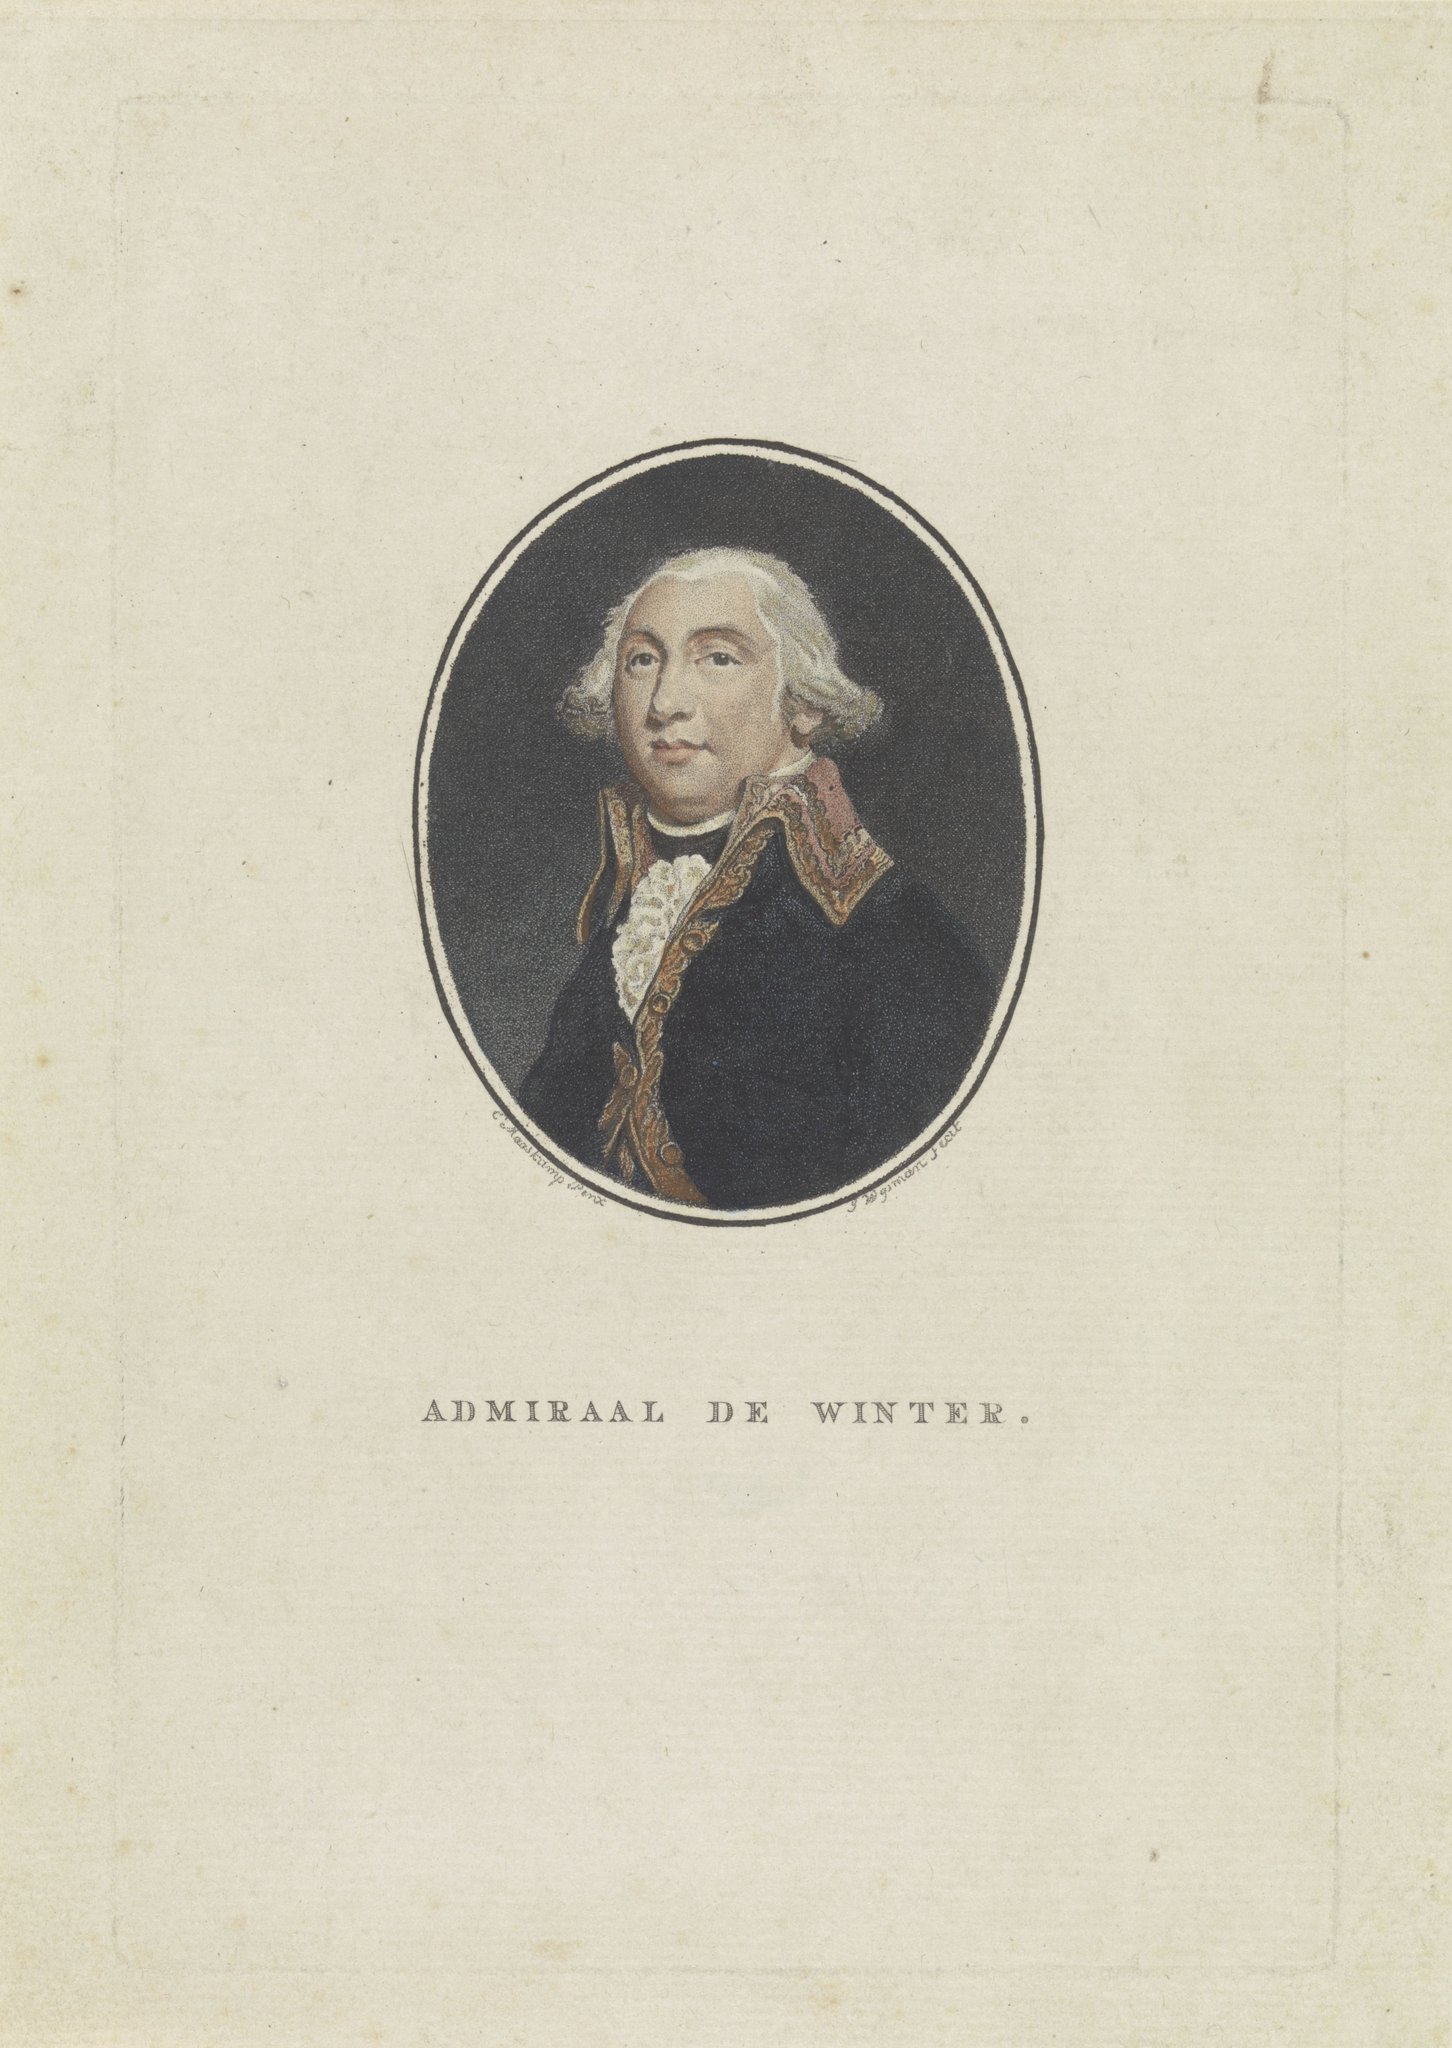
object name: print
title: Portret van Jan Willem de Winter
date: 1795-1812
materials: paper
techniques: etching, hand coloring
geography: amsterdam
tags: paris, jan willem de winter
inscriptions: collector's mark: Lugt 2760, collector's mark: Lugt 2228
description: Portret van Jan Willem de Winter, admiraal en aanvoerder van de Hollandse vloot.